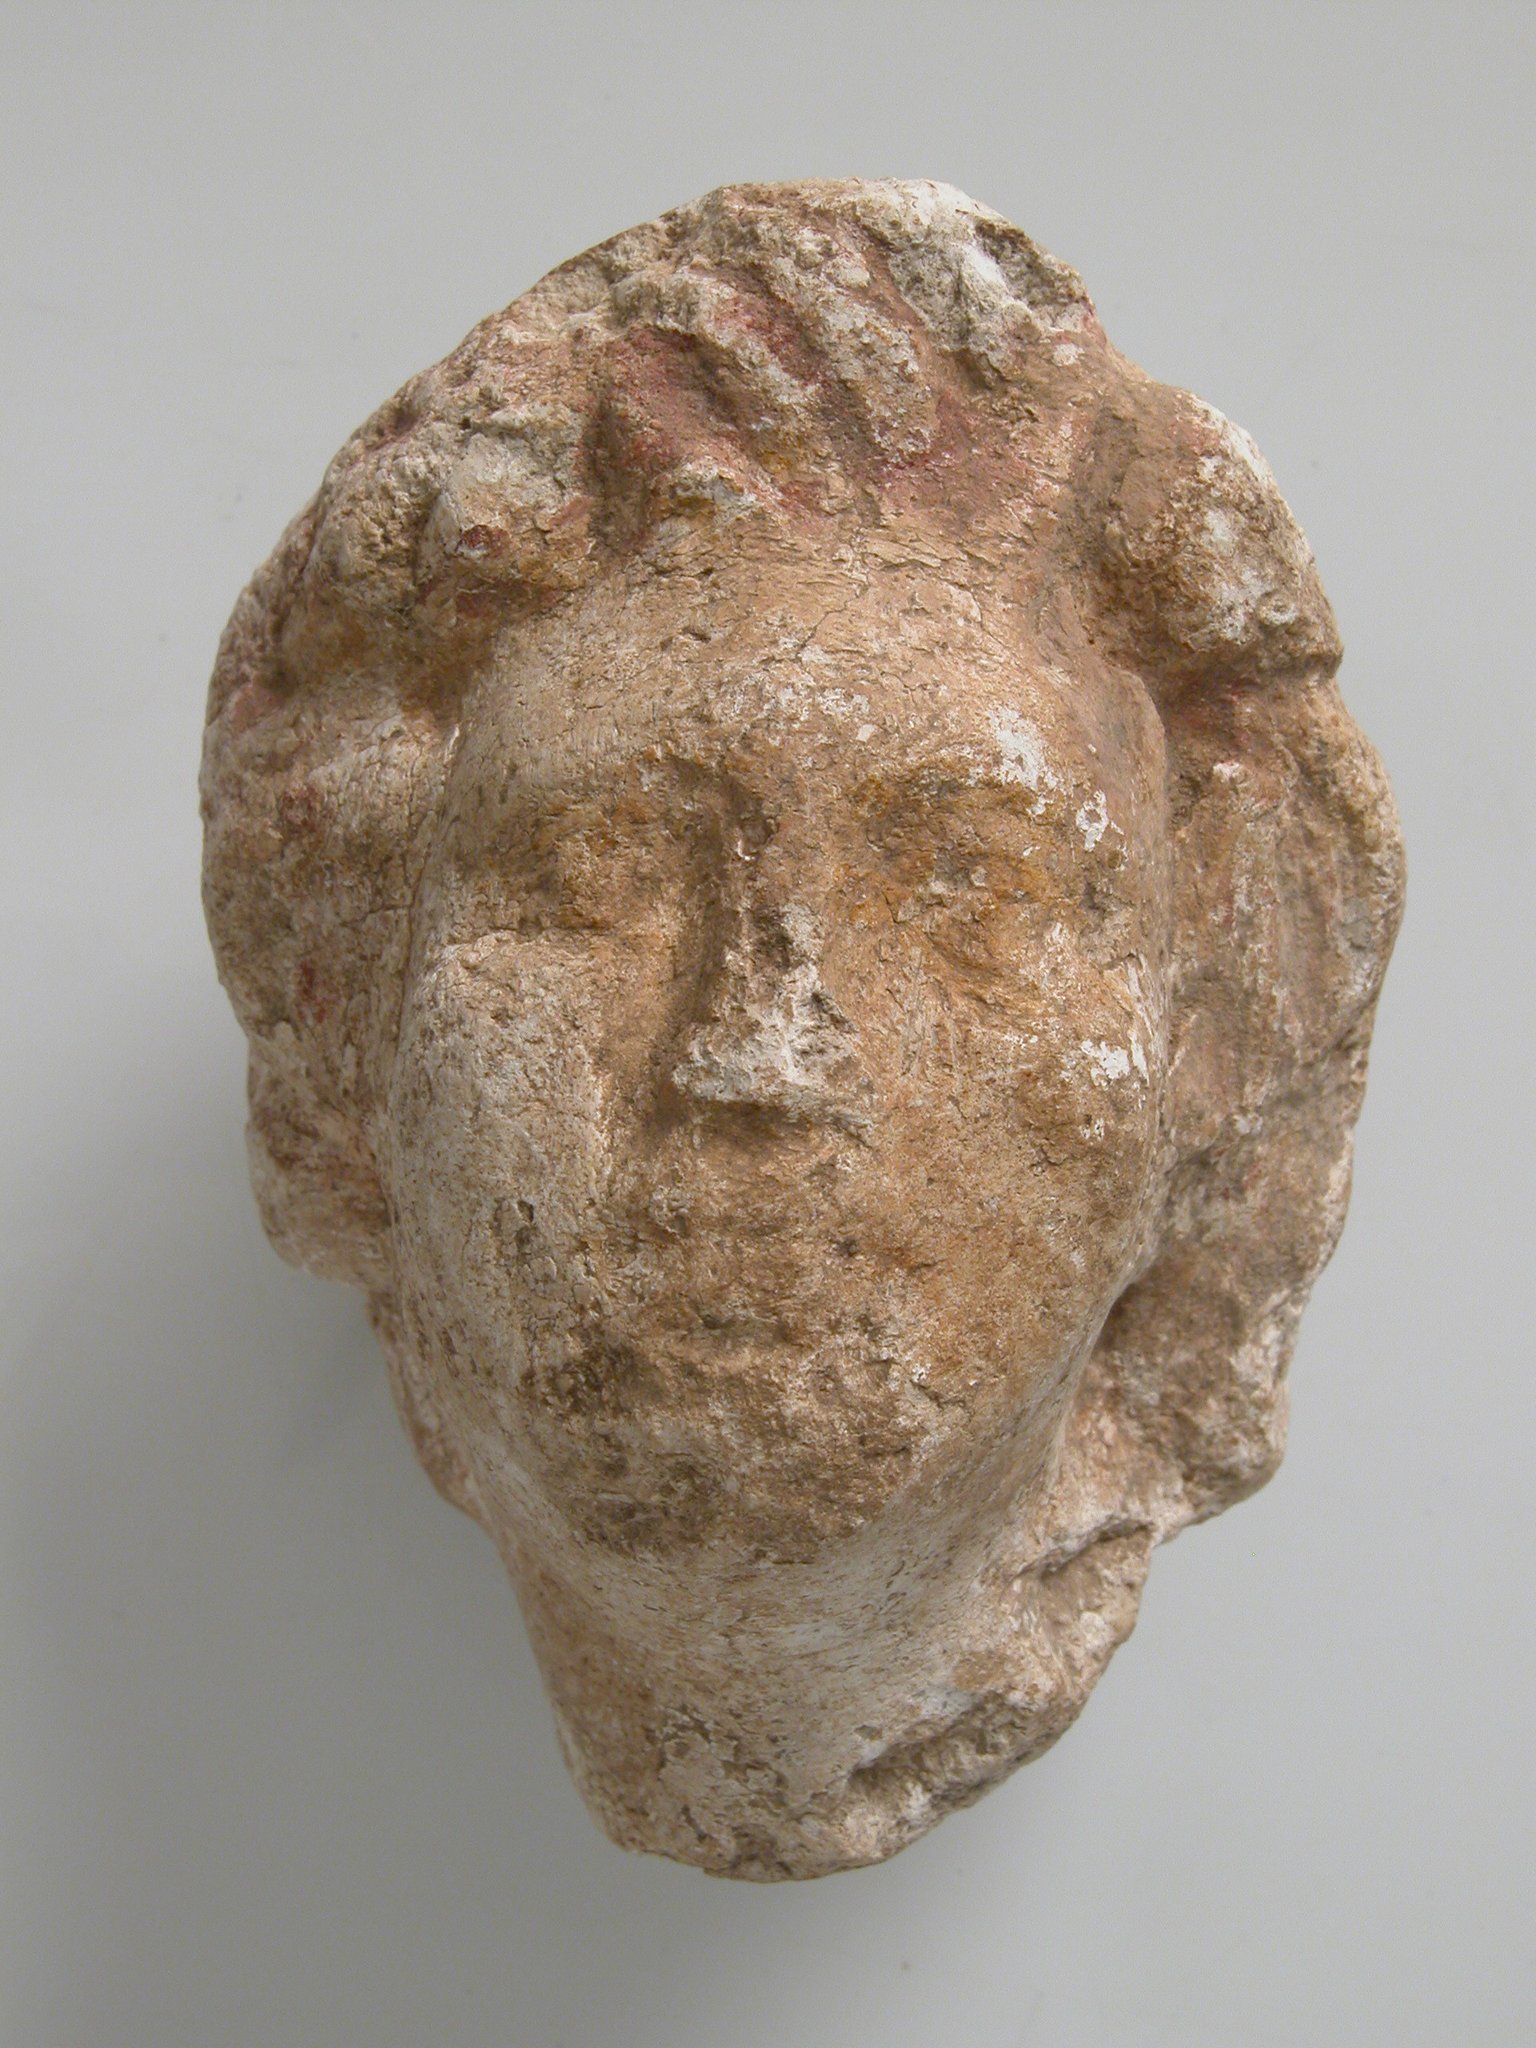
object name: statuette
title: Head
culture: coptic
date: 301-700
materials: stone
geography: egypt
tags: heads